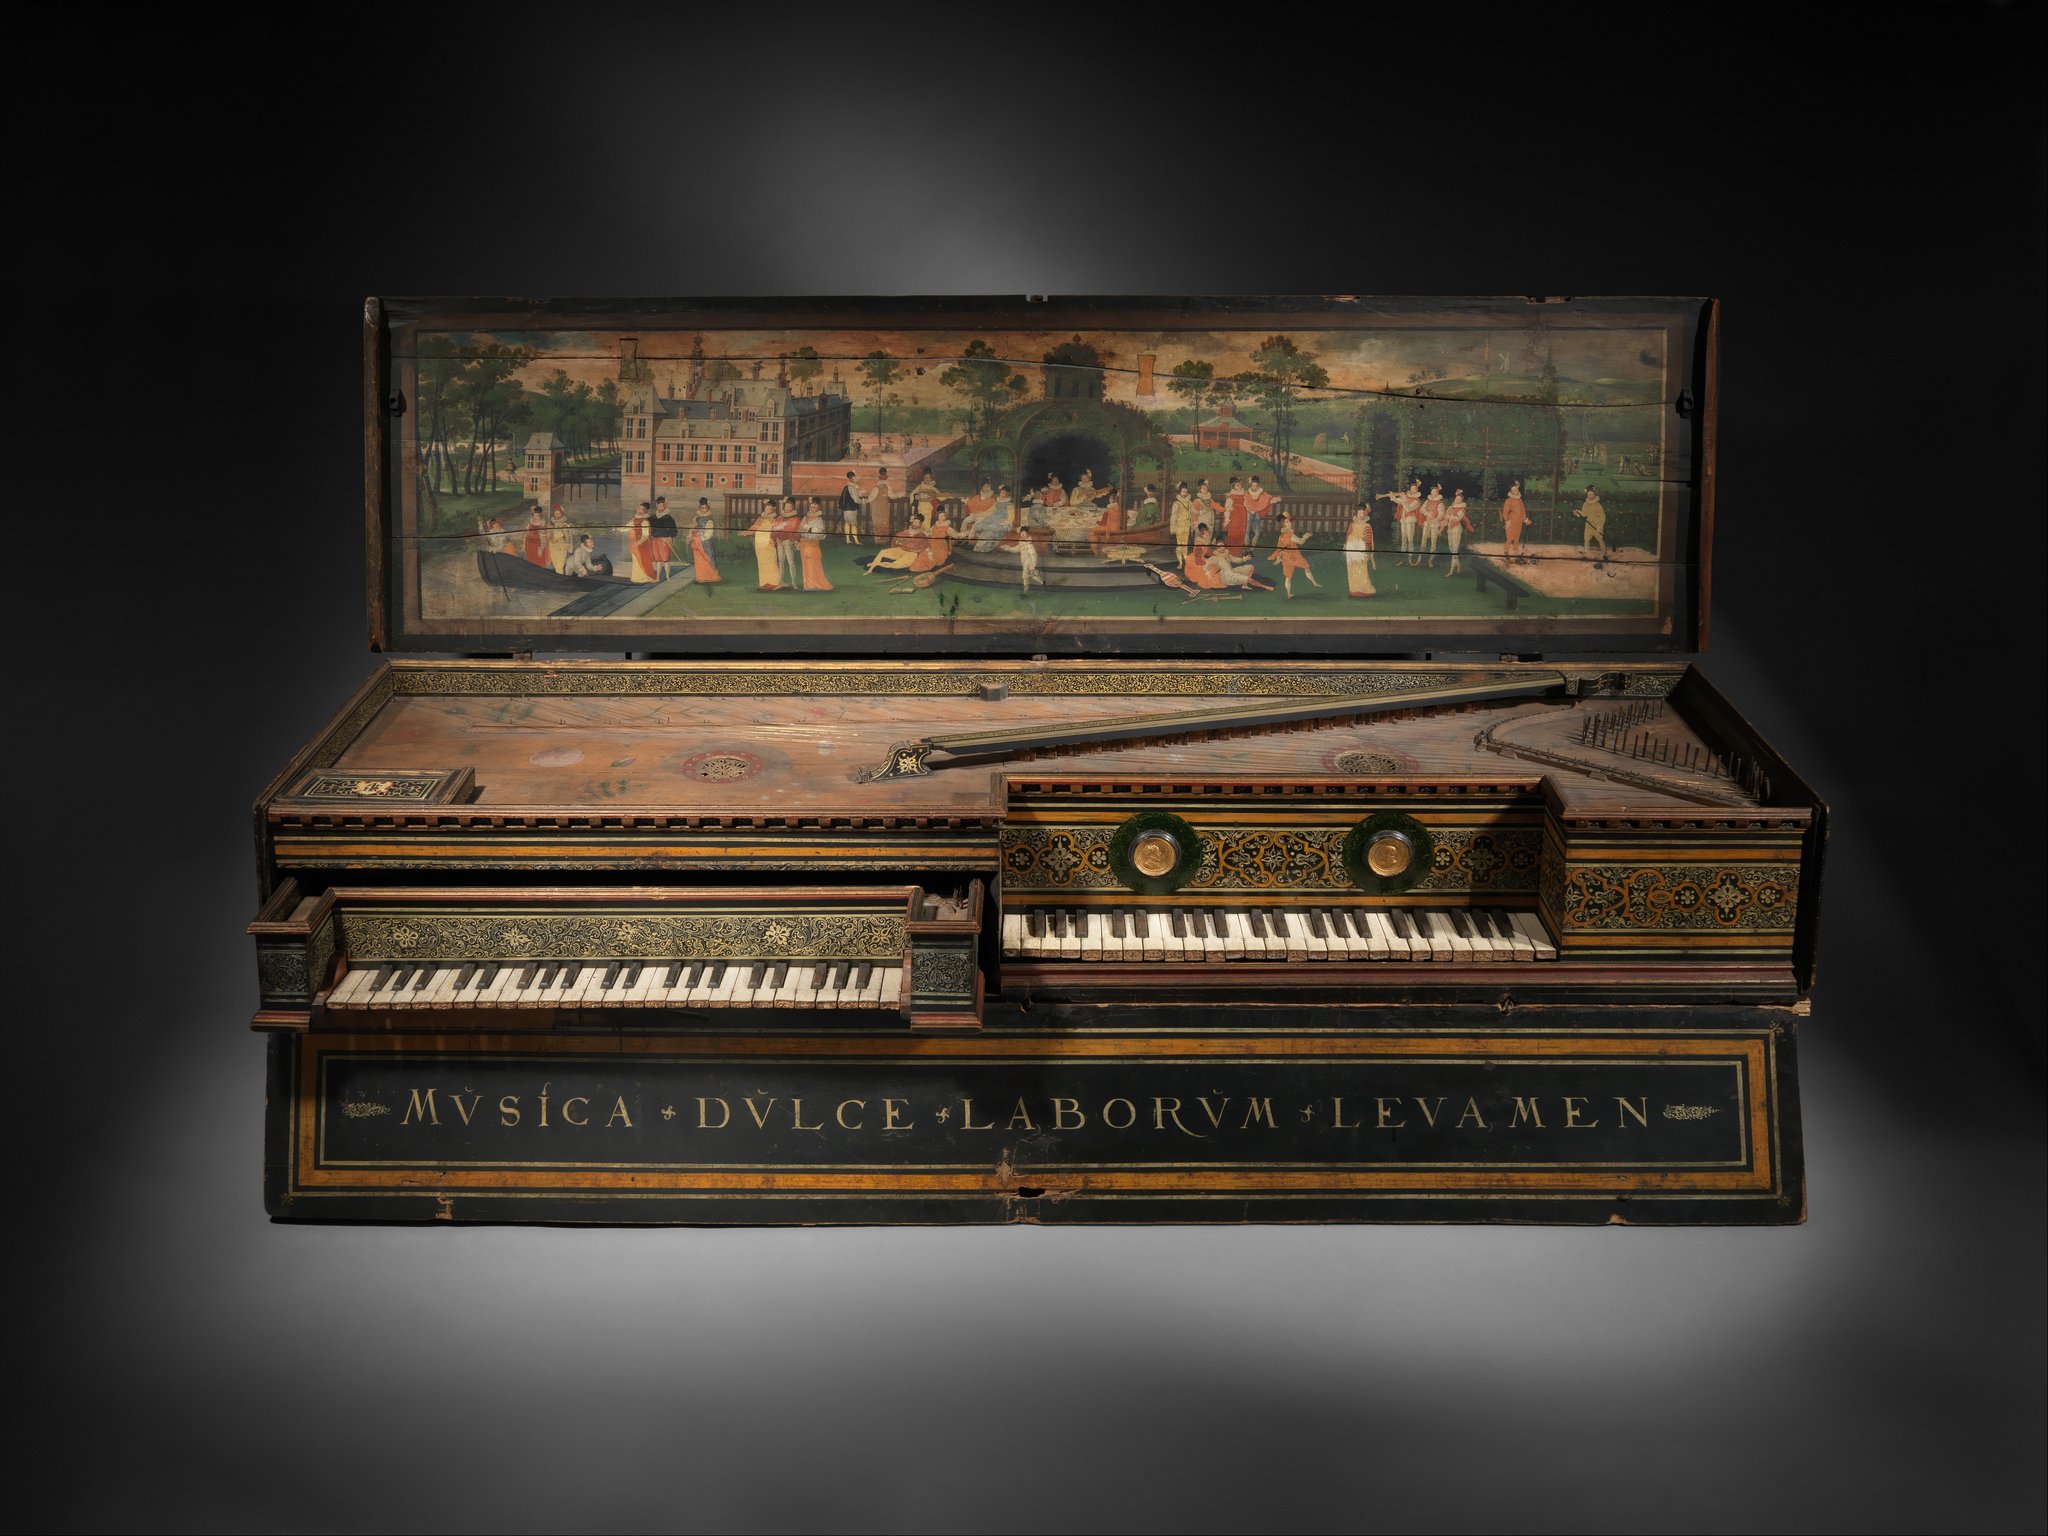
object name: double virginal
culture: flemish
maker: hans ruckers the elder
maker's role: maker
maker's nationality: flemish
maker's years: 1545-1598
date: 1581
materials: wood, brass, gesso, metal, paint, parchment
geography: belgium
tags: gardens,men,women